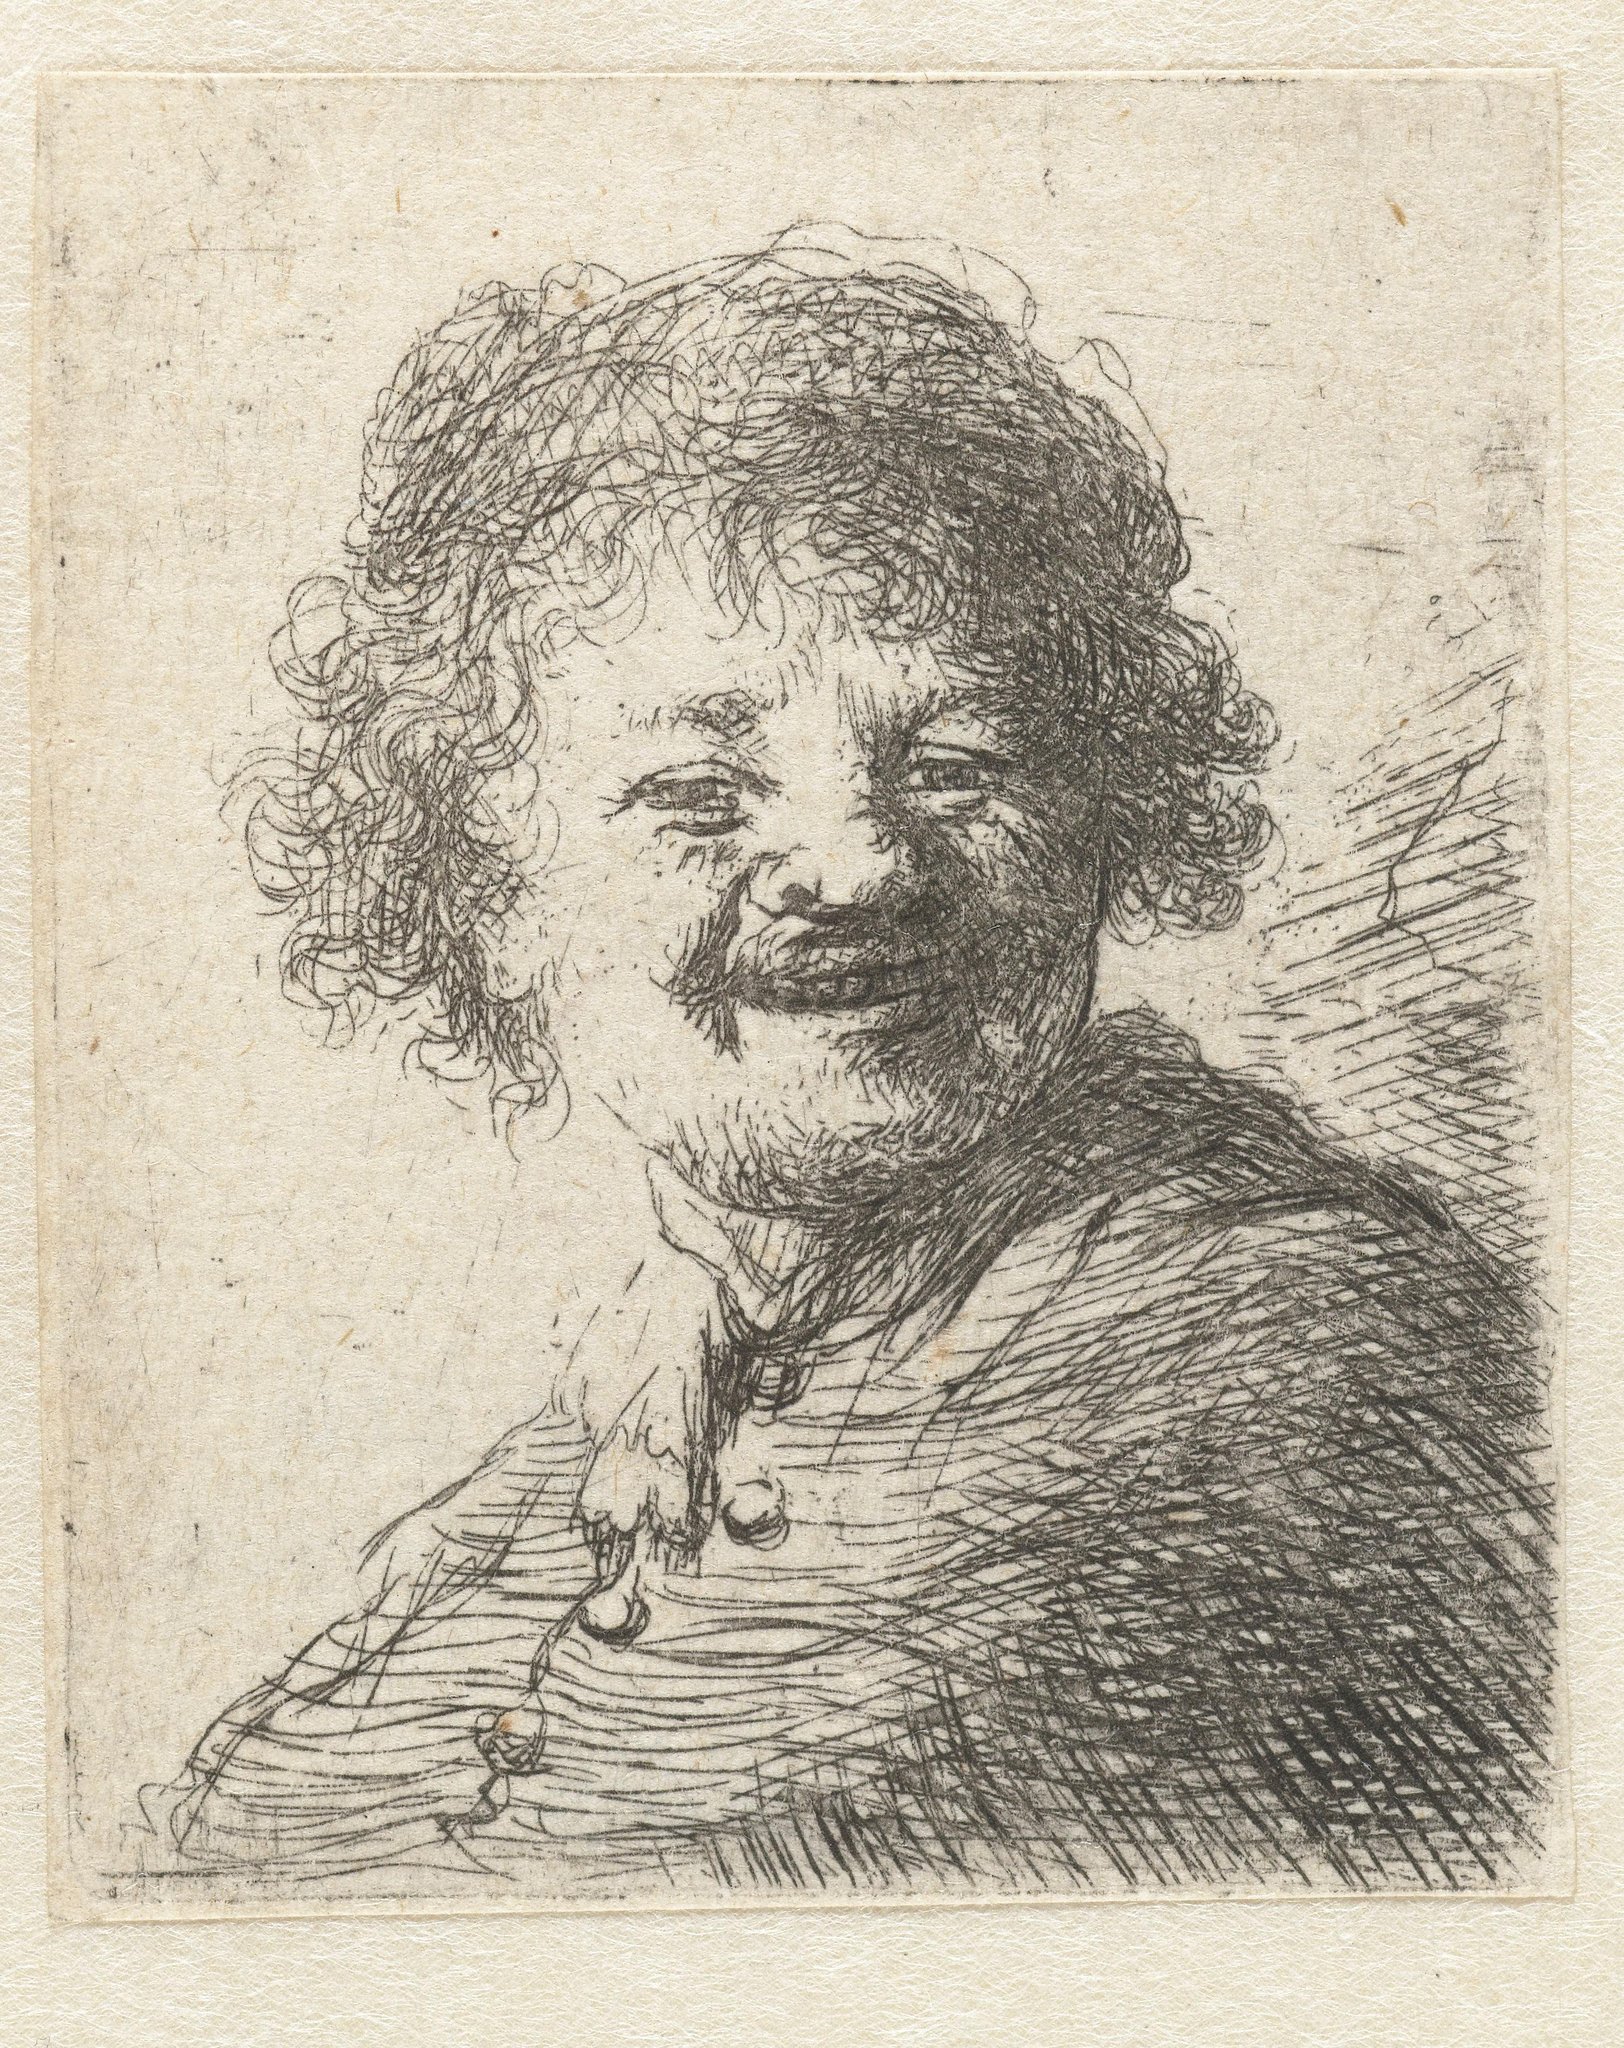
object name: print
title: Self-portrait in a cap: laughing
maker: Anonymous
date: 1630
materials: paper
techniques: etching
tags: leiden, amsterdam, painter, print maker, rembrandt van rijn, head-gear: cap (+ men's clothes), laughing, portrait, self-portrait of graphic artist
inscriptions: collector's mark: Lugt 240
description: Spiegelbeeldige kopie naar de gelijknamige prent van Rembrandt.